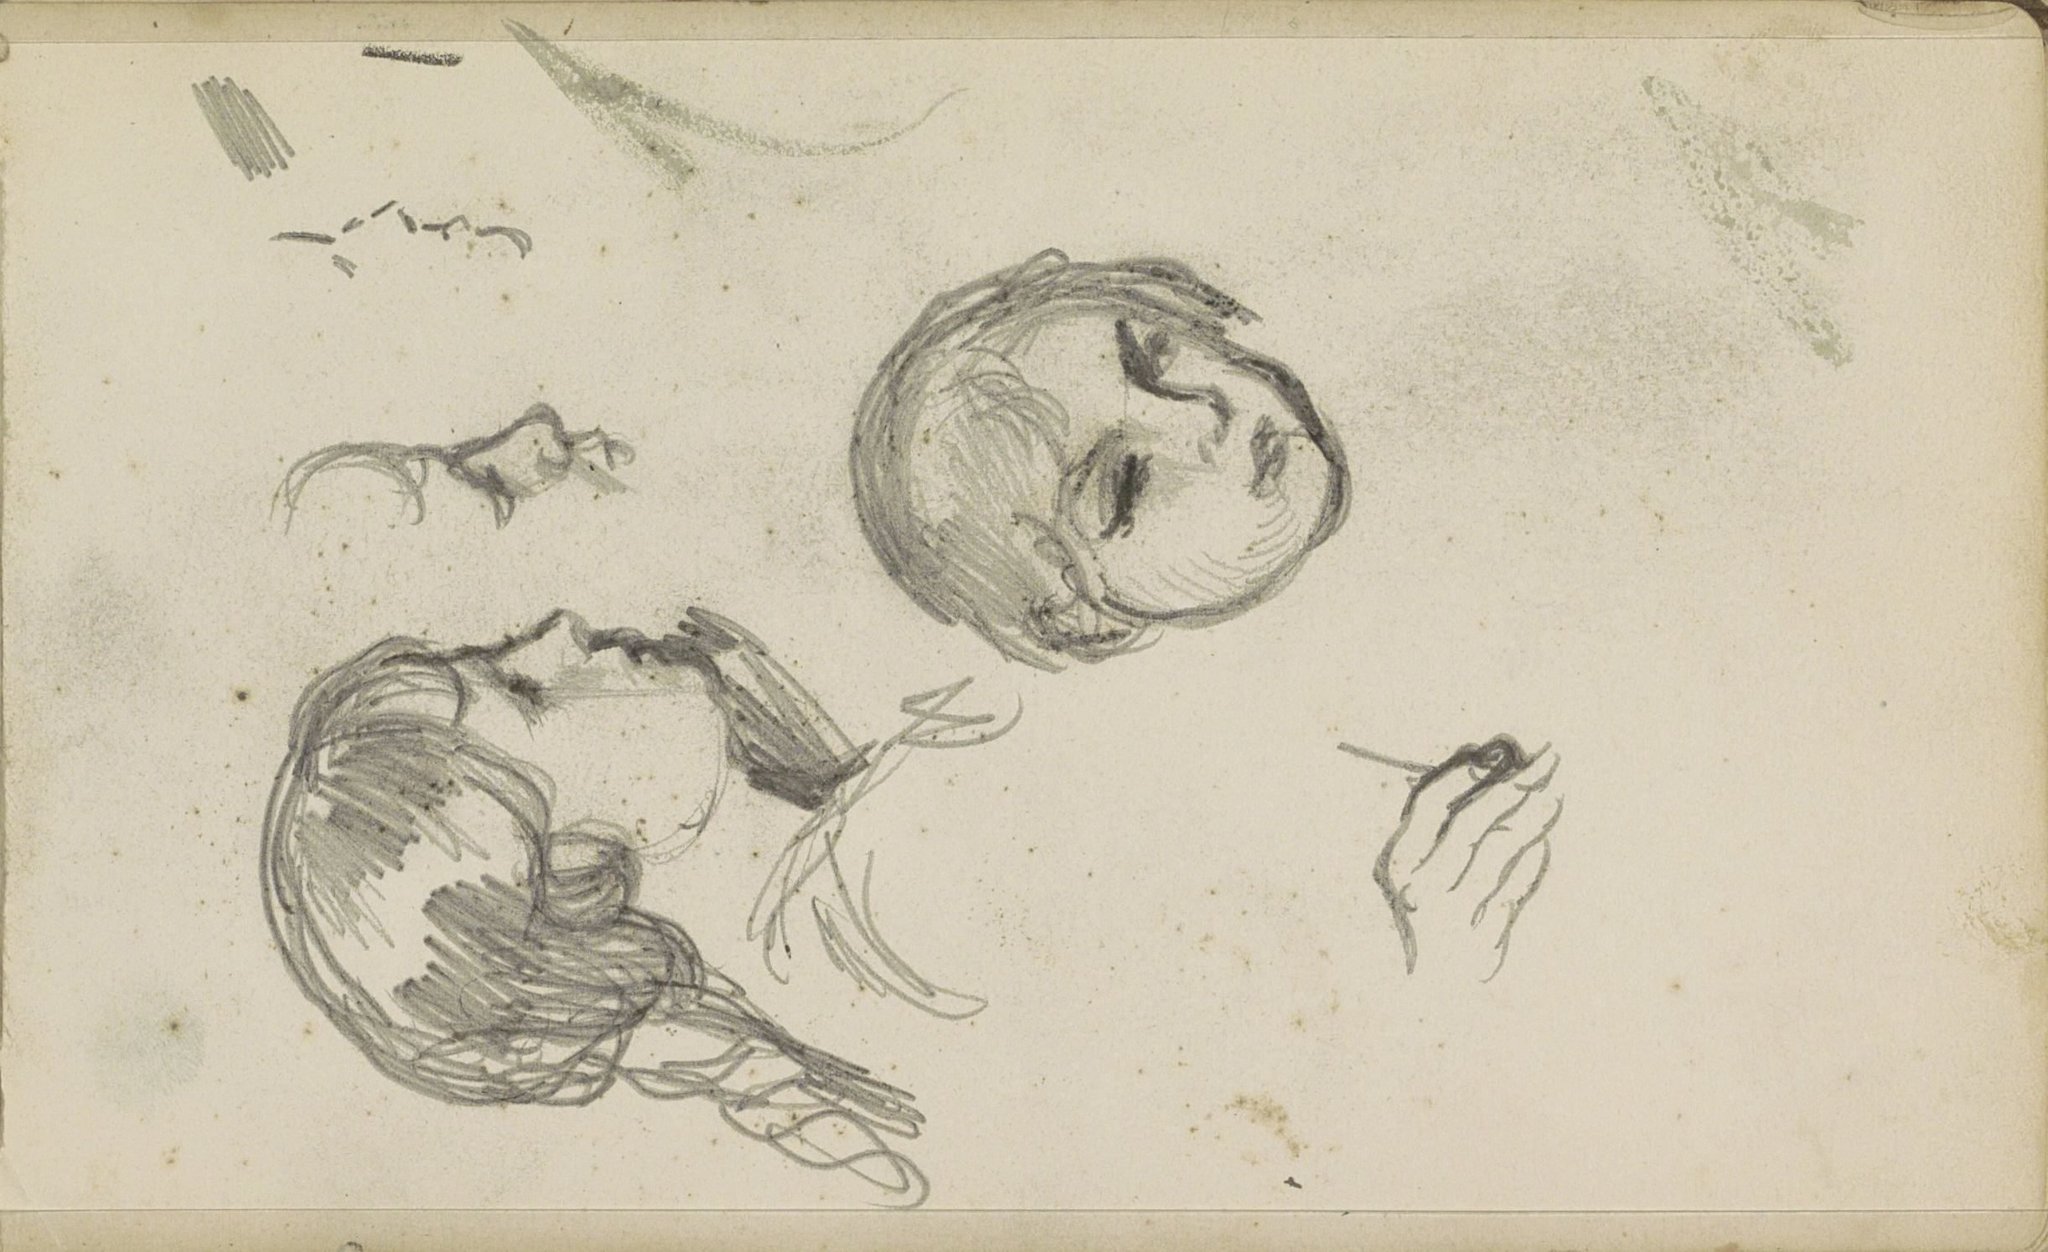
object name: sketchbook leaf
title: Koppen van twee meisjes en een schrijvende hand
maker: jozef israëls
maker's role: draughtsman, painter, print maker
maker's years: 1824-1911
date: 1834-1911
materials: paper, pencil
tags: head (human), hand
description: Blad 10 recto uit een schetsboek met 42 bladen.